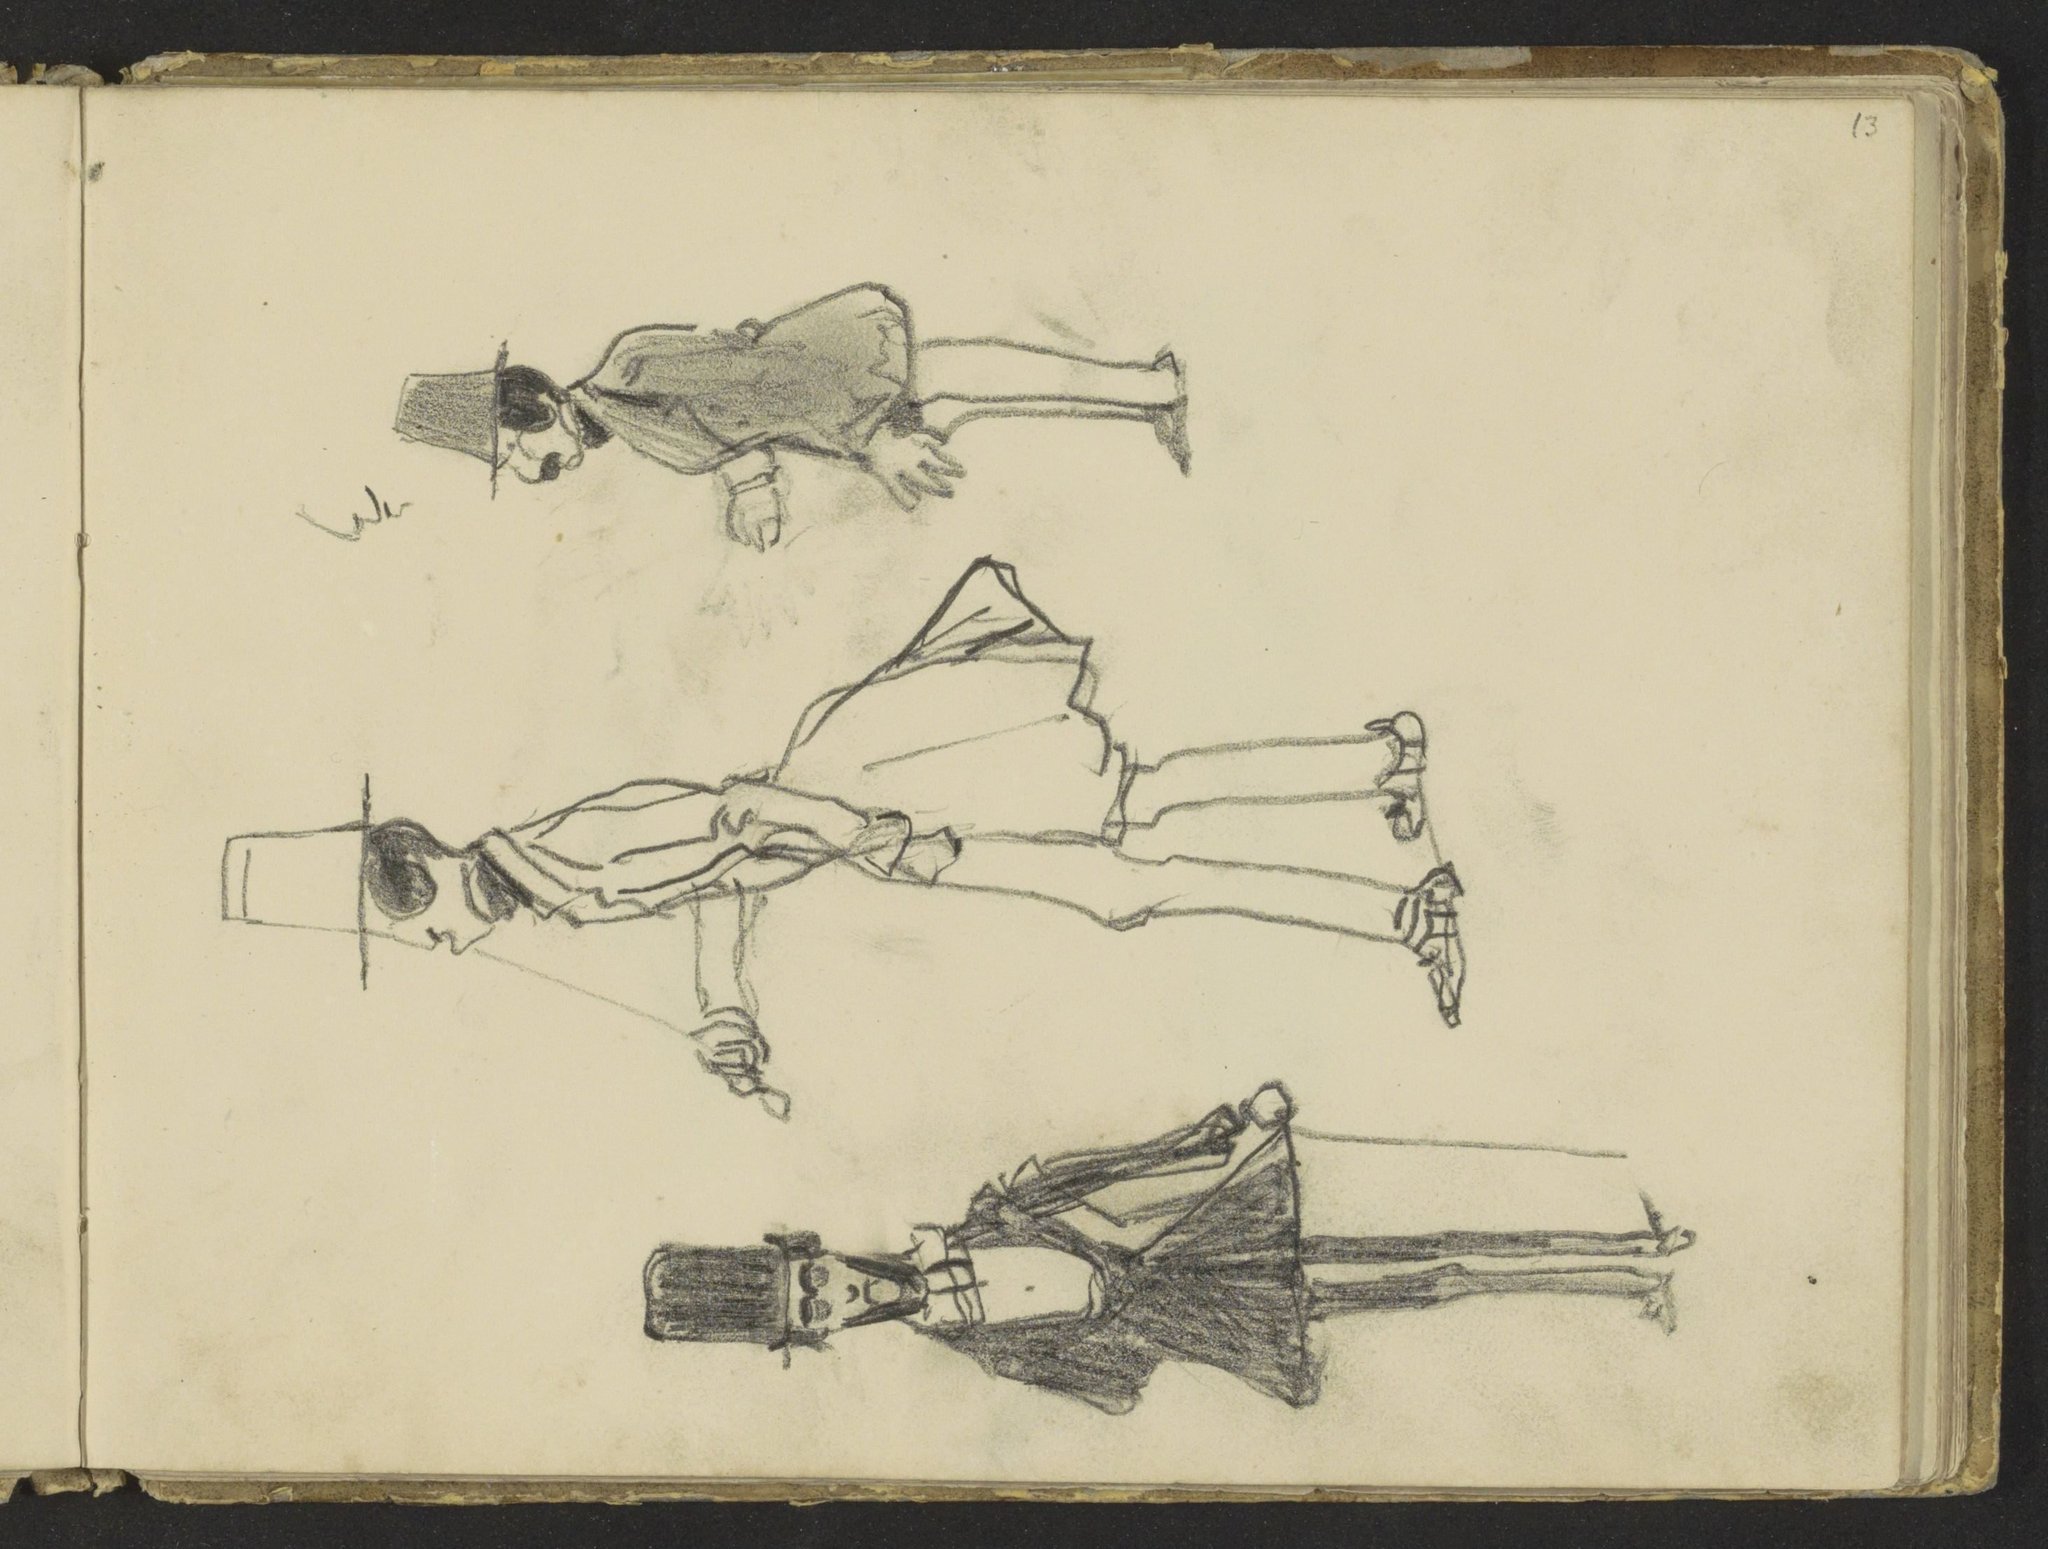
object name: sketchbook leaf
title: Drie mannen met hoge hoeden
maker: willem hendrik schmidt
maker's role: draughtsman, painter, print maker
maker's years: 1809-1849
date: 1819-1849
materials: paper, pencil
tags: 41d221(top hat)(+81)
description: Blad 13 recto uit een schetsboek met 36 bladen.